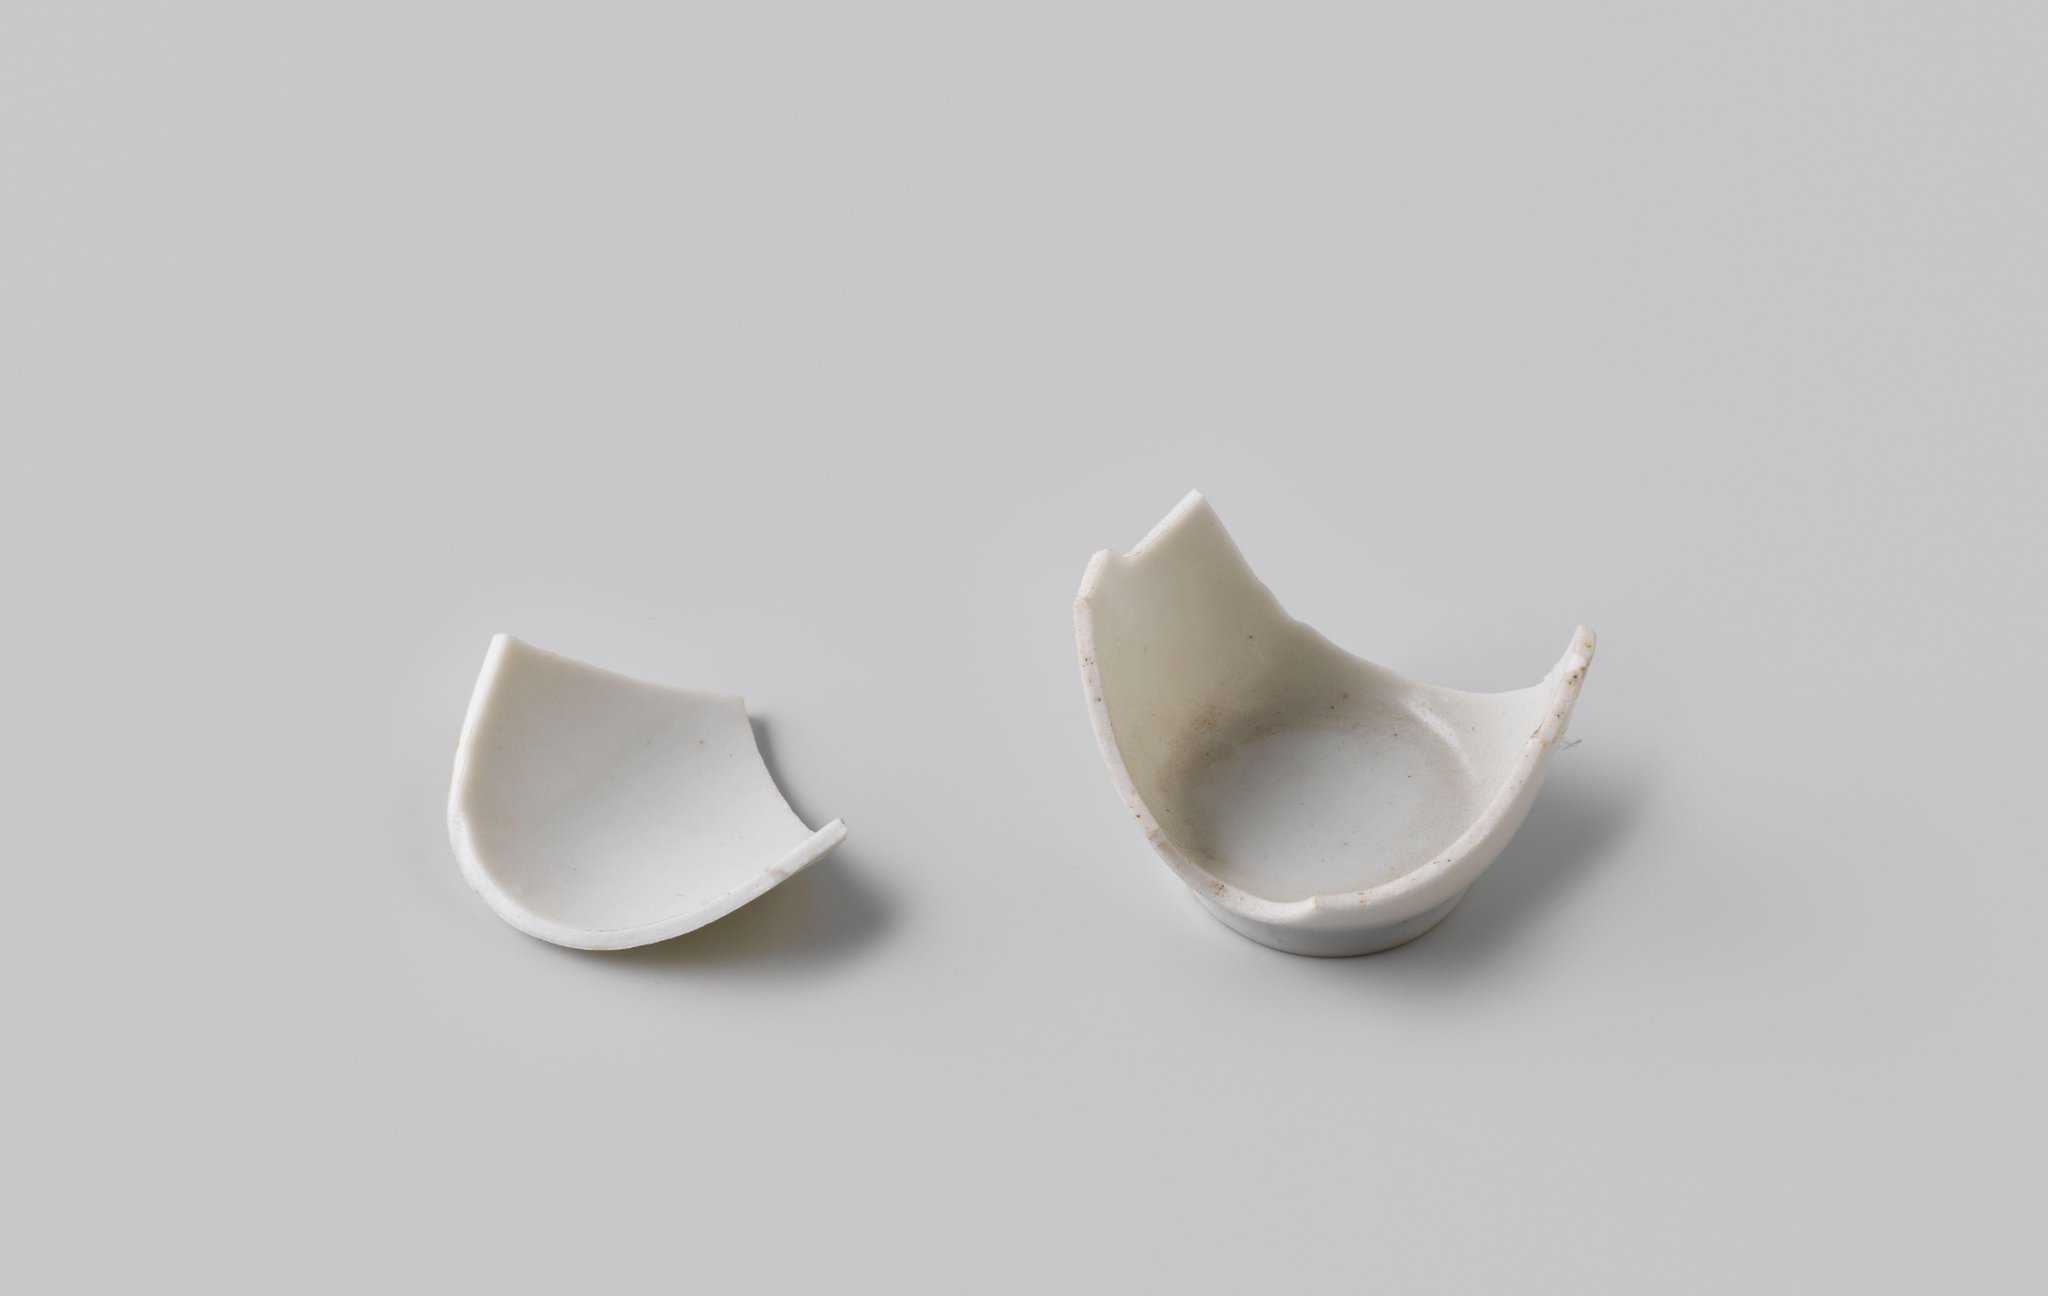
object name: wine cup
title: Scherven van een wijnkom uit V.O.C.-schip de 'Witte Leeuw'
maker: Anonymous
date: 1613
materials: porcelain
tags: verenigde oostindische compagnie, sint-helena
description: Scherven van een wijnkom uit V.O.C.-schip de 'Witte Leeuw'.